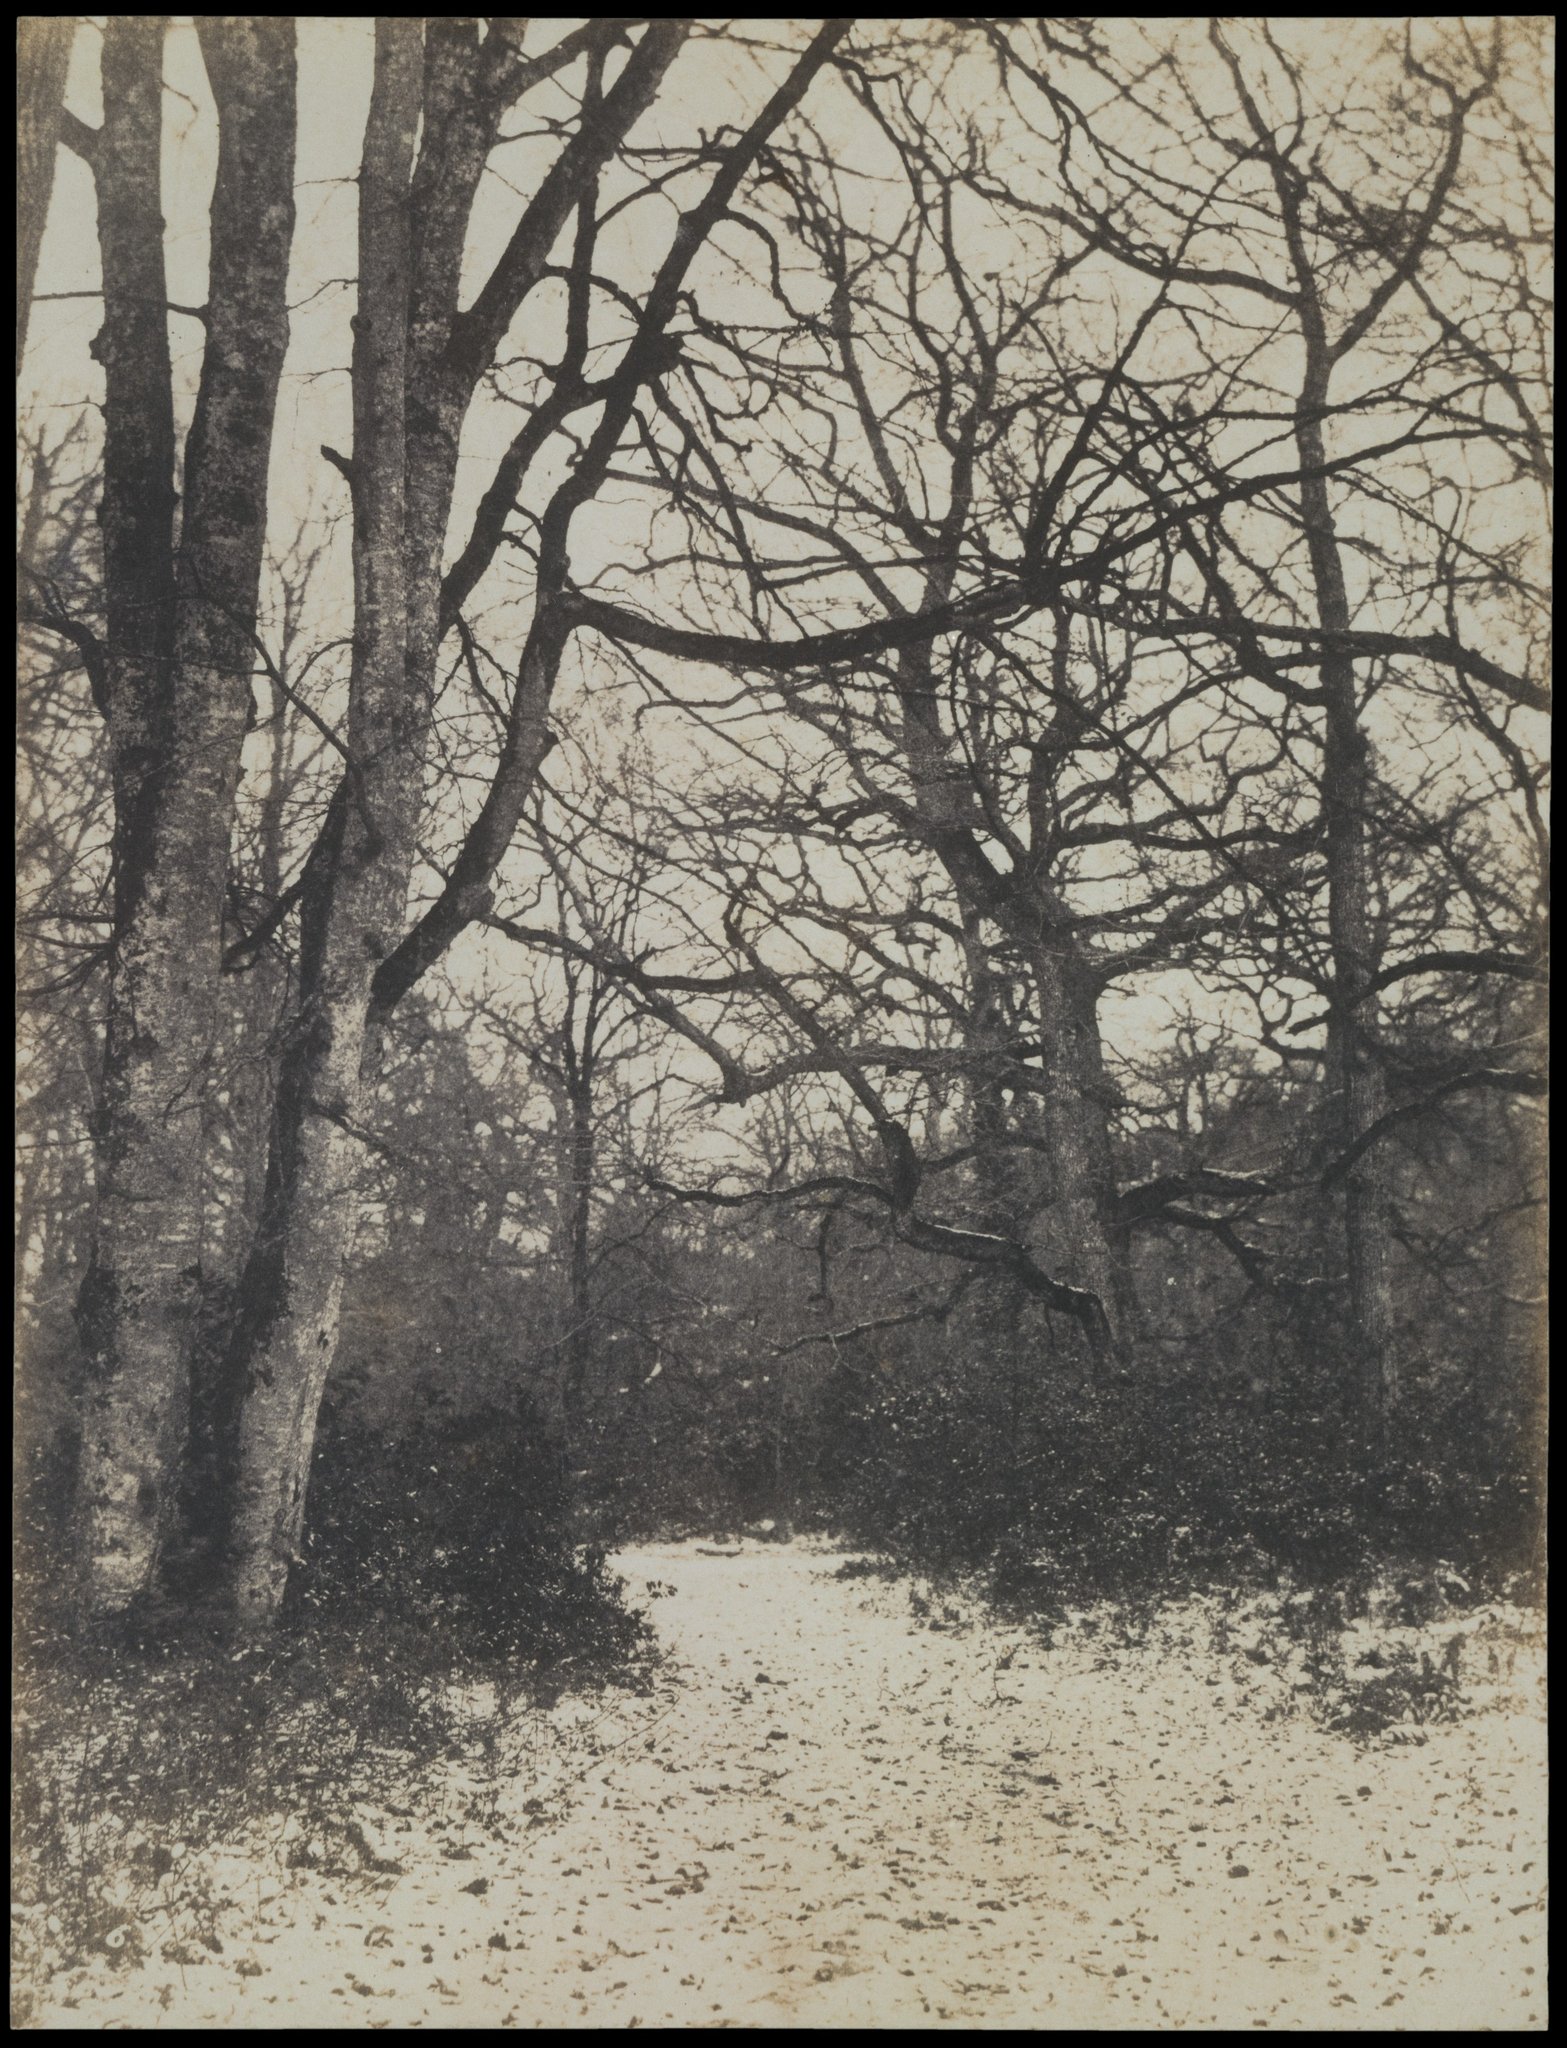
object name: photograph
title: [Fontainebleau Forest]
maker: eugène cuvelier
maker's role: artist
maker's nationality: french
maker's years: 1837-1900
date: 1860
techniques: paper negative, salted paper print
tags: forests,landscapes